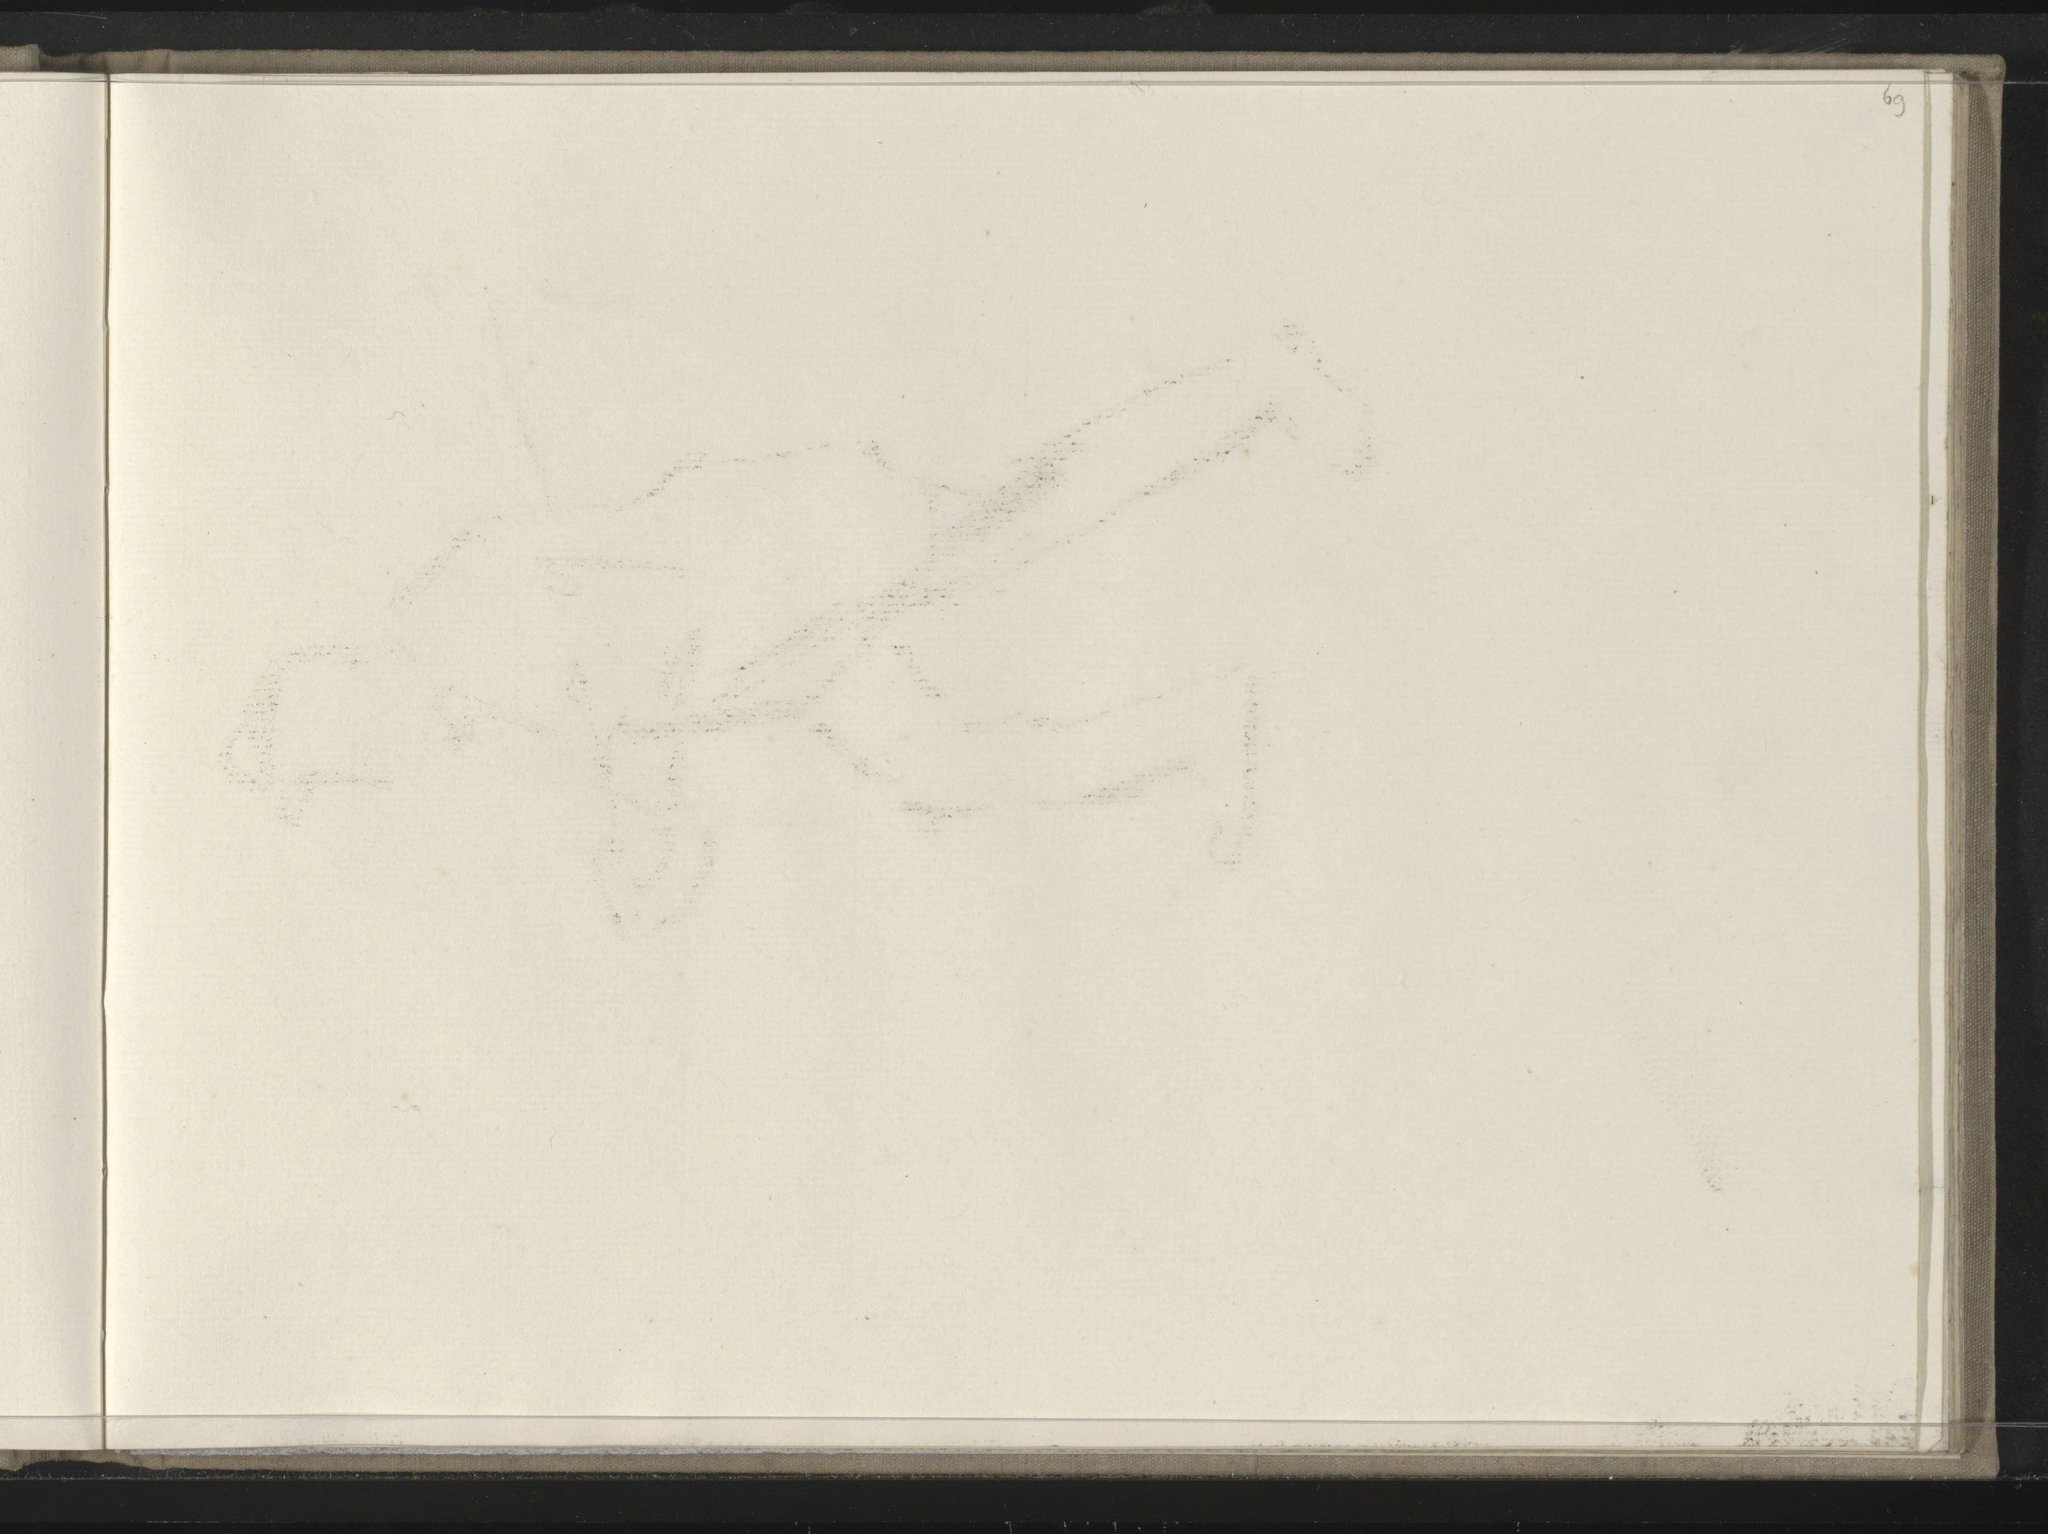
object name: sketchbook leaf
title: Abklatsch van de krijttekening op pagina 68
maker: willem witsen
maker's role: draughtsman, painter, print maker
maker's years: 1860-1923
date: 1888-1907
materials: paper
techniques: printmaking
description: Pagina 69 uit een schetsboek met 72 bladen.